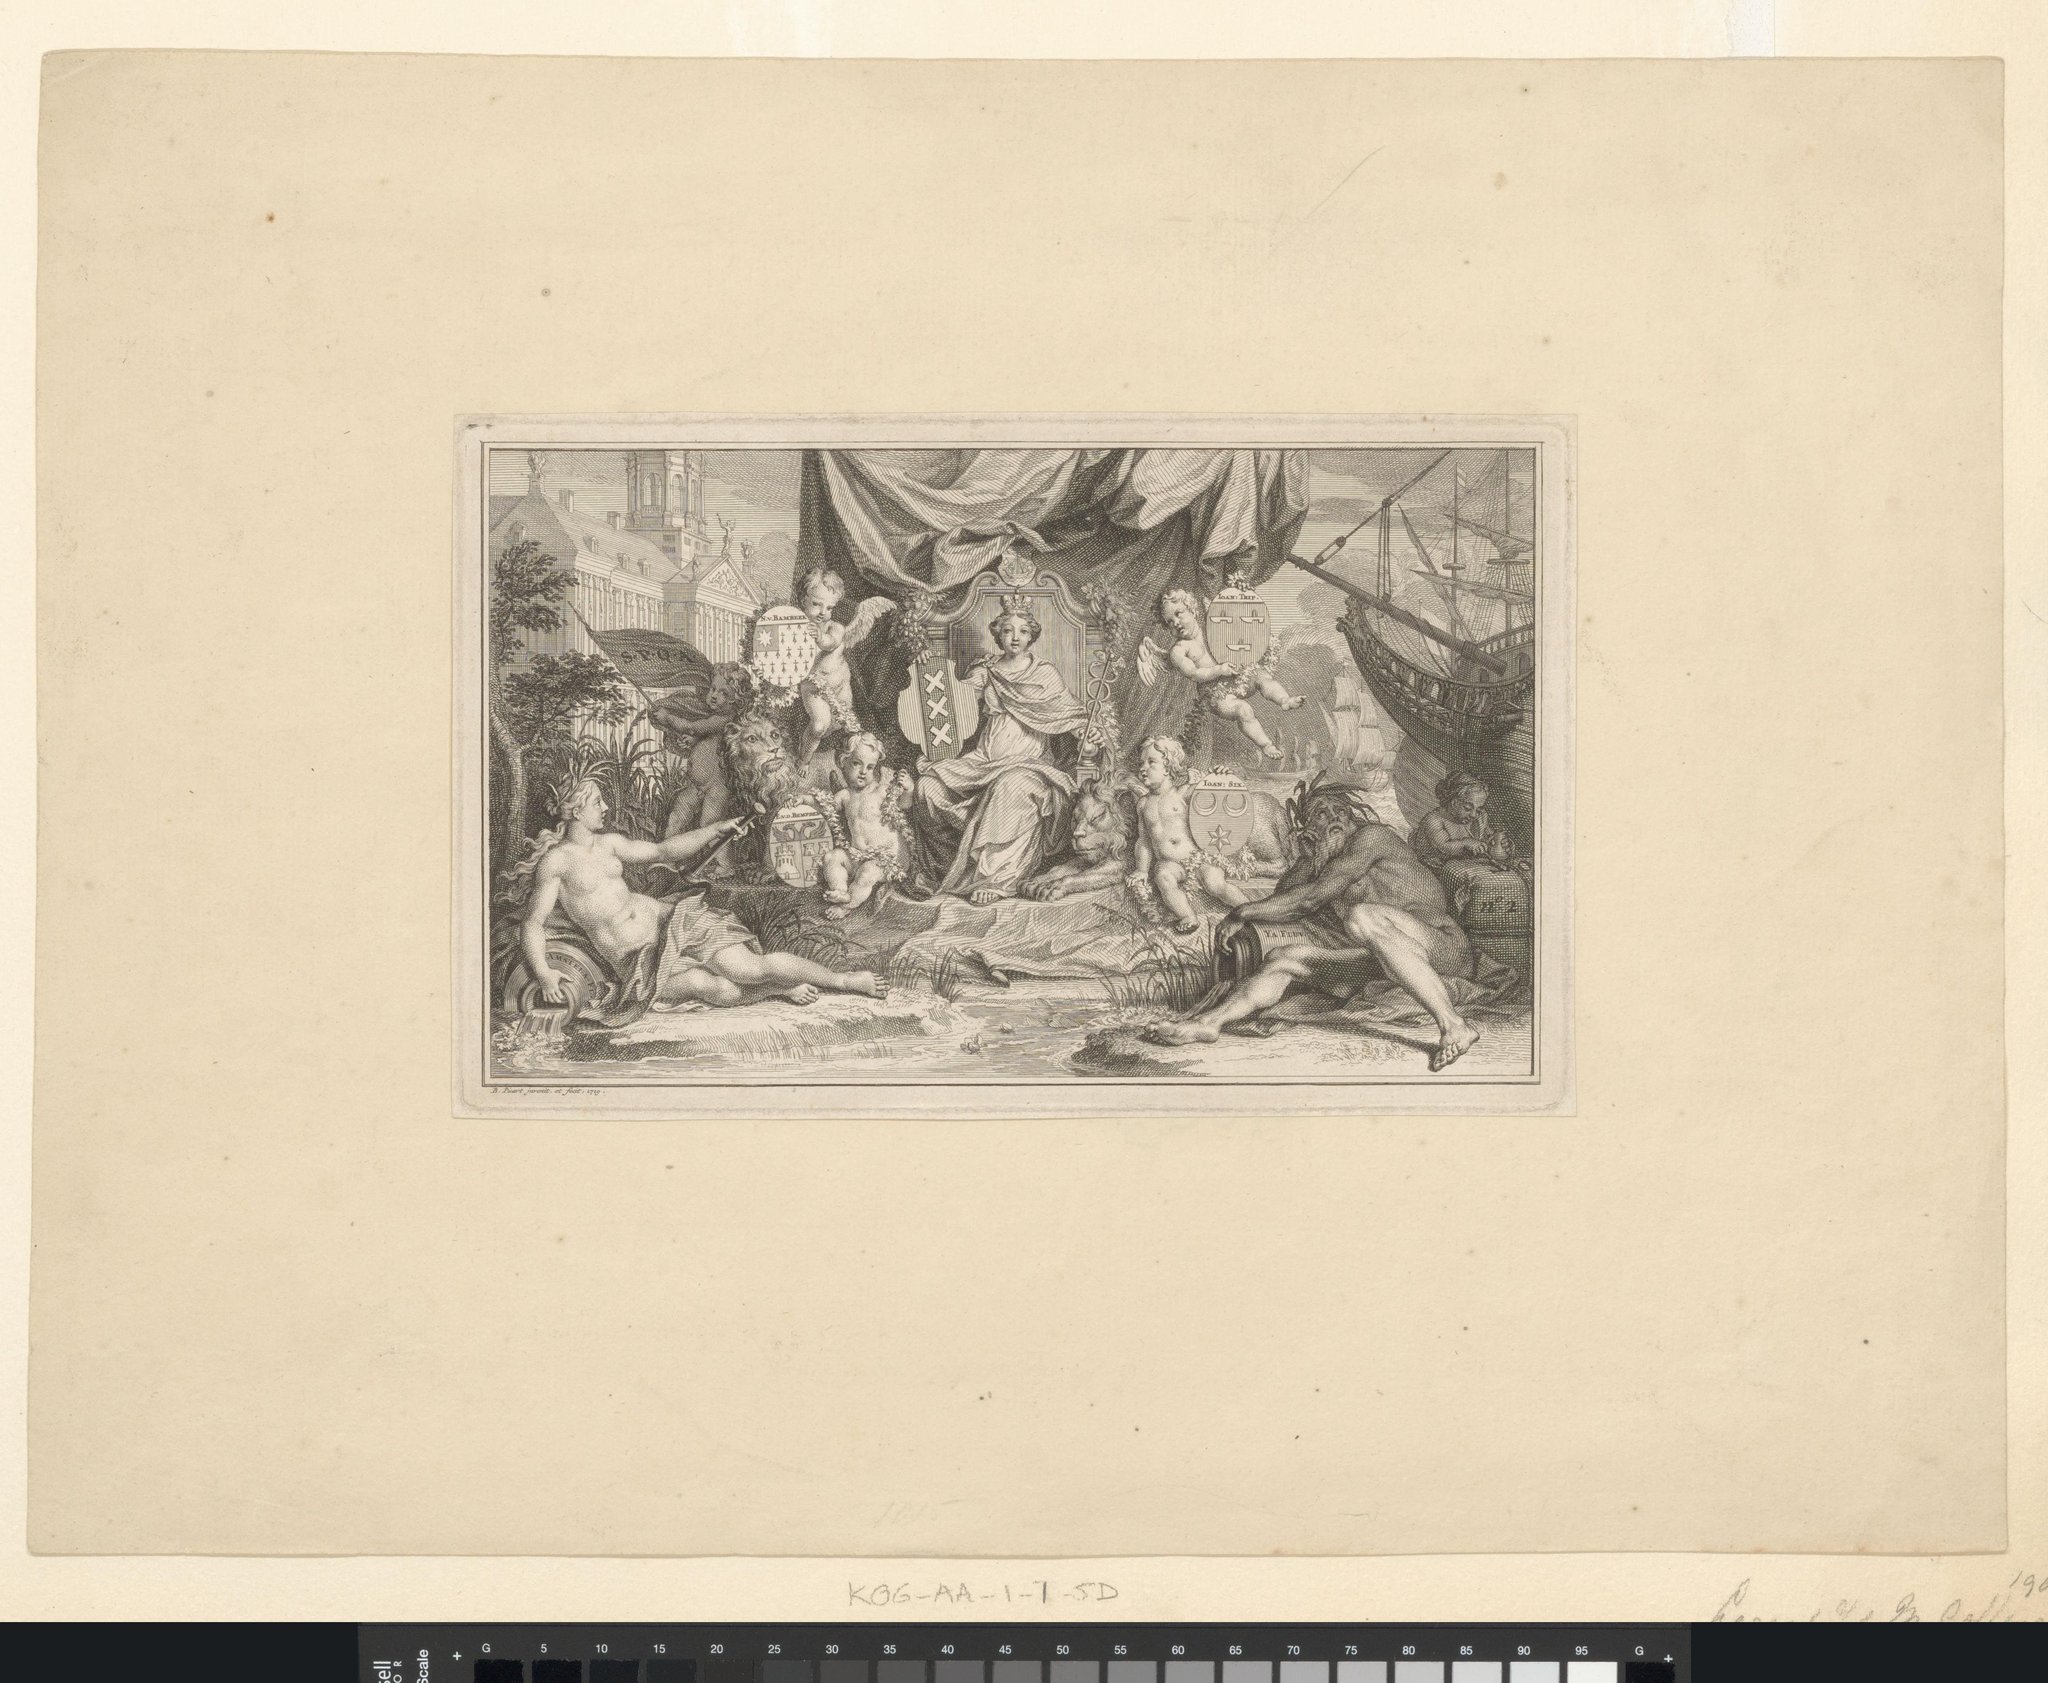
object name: print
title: Amsterdamse Stedenmaagd omringd door wapenschilden van burgemeesters van Amsterdam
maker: bernard picart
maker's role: draughtsman, print maker, publisher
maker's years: 1673-1733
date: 1719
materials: paper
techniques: engraving, etching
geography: amsterdam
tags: amsterdam, jan six (1668-1750), mayor, personifications of countries, nations, states, districts, etc., river personified, 'fiumi' (ripa), armorial bearing, heraldry, city represented symbolically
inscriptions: inscription: ‘Legaat Joh. M. Coffeng / 1966’, collector's mark: ‘1A’ Lugt 1641b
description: Onderwerpsrubriek binnen de Atlas Amsterdam: Titels en voorberichten.